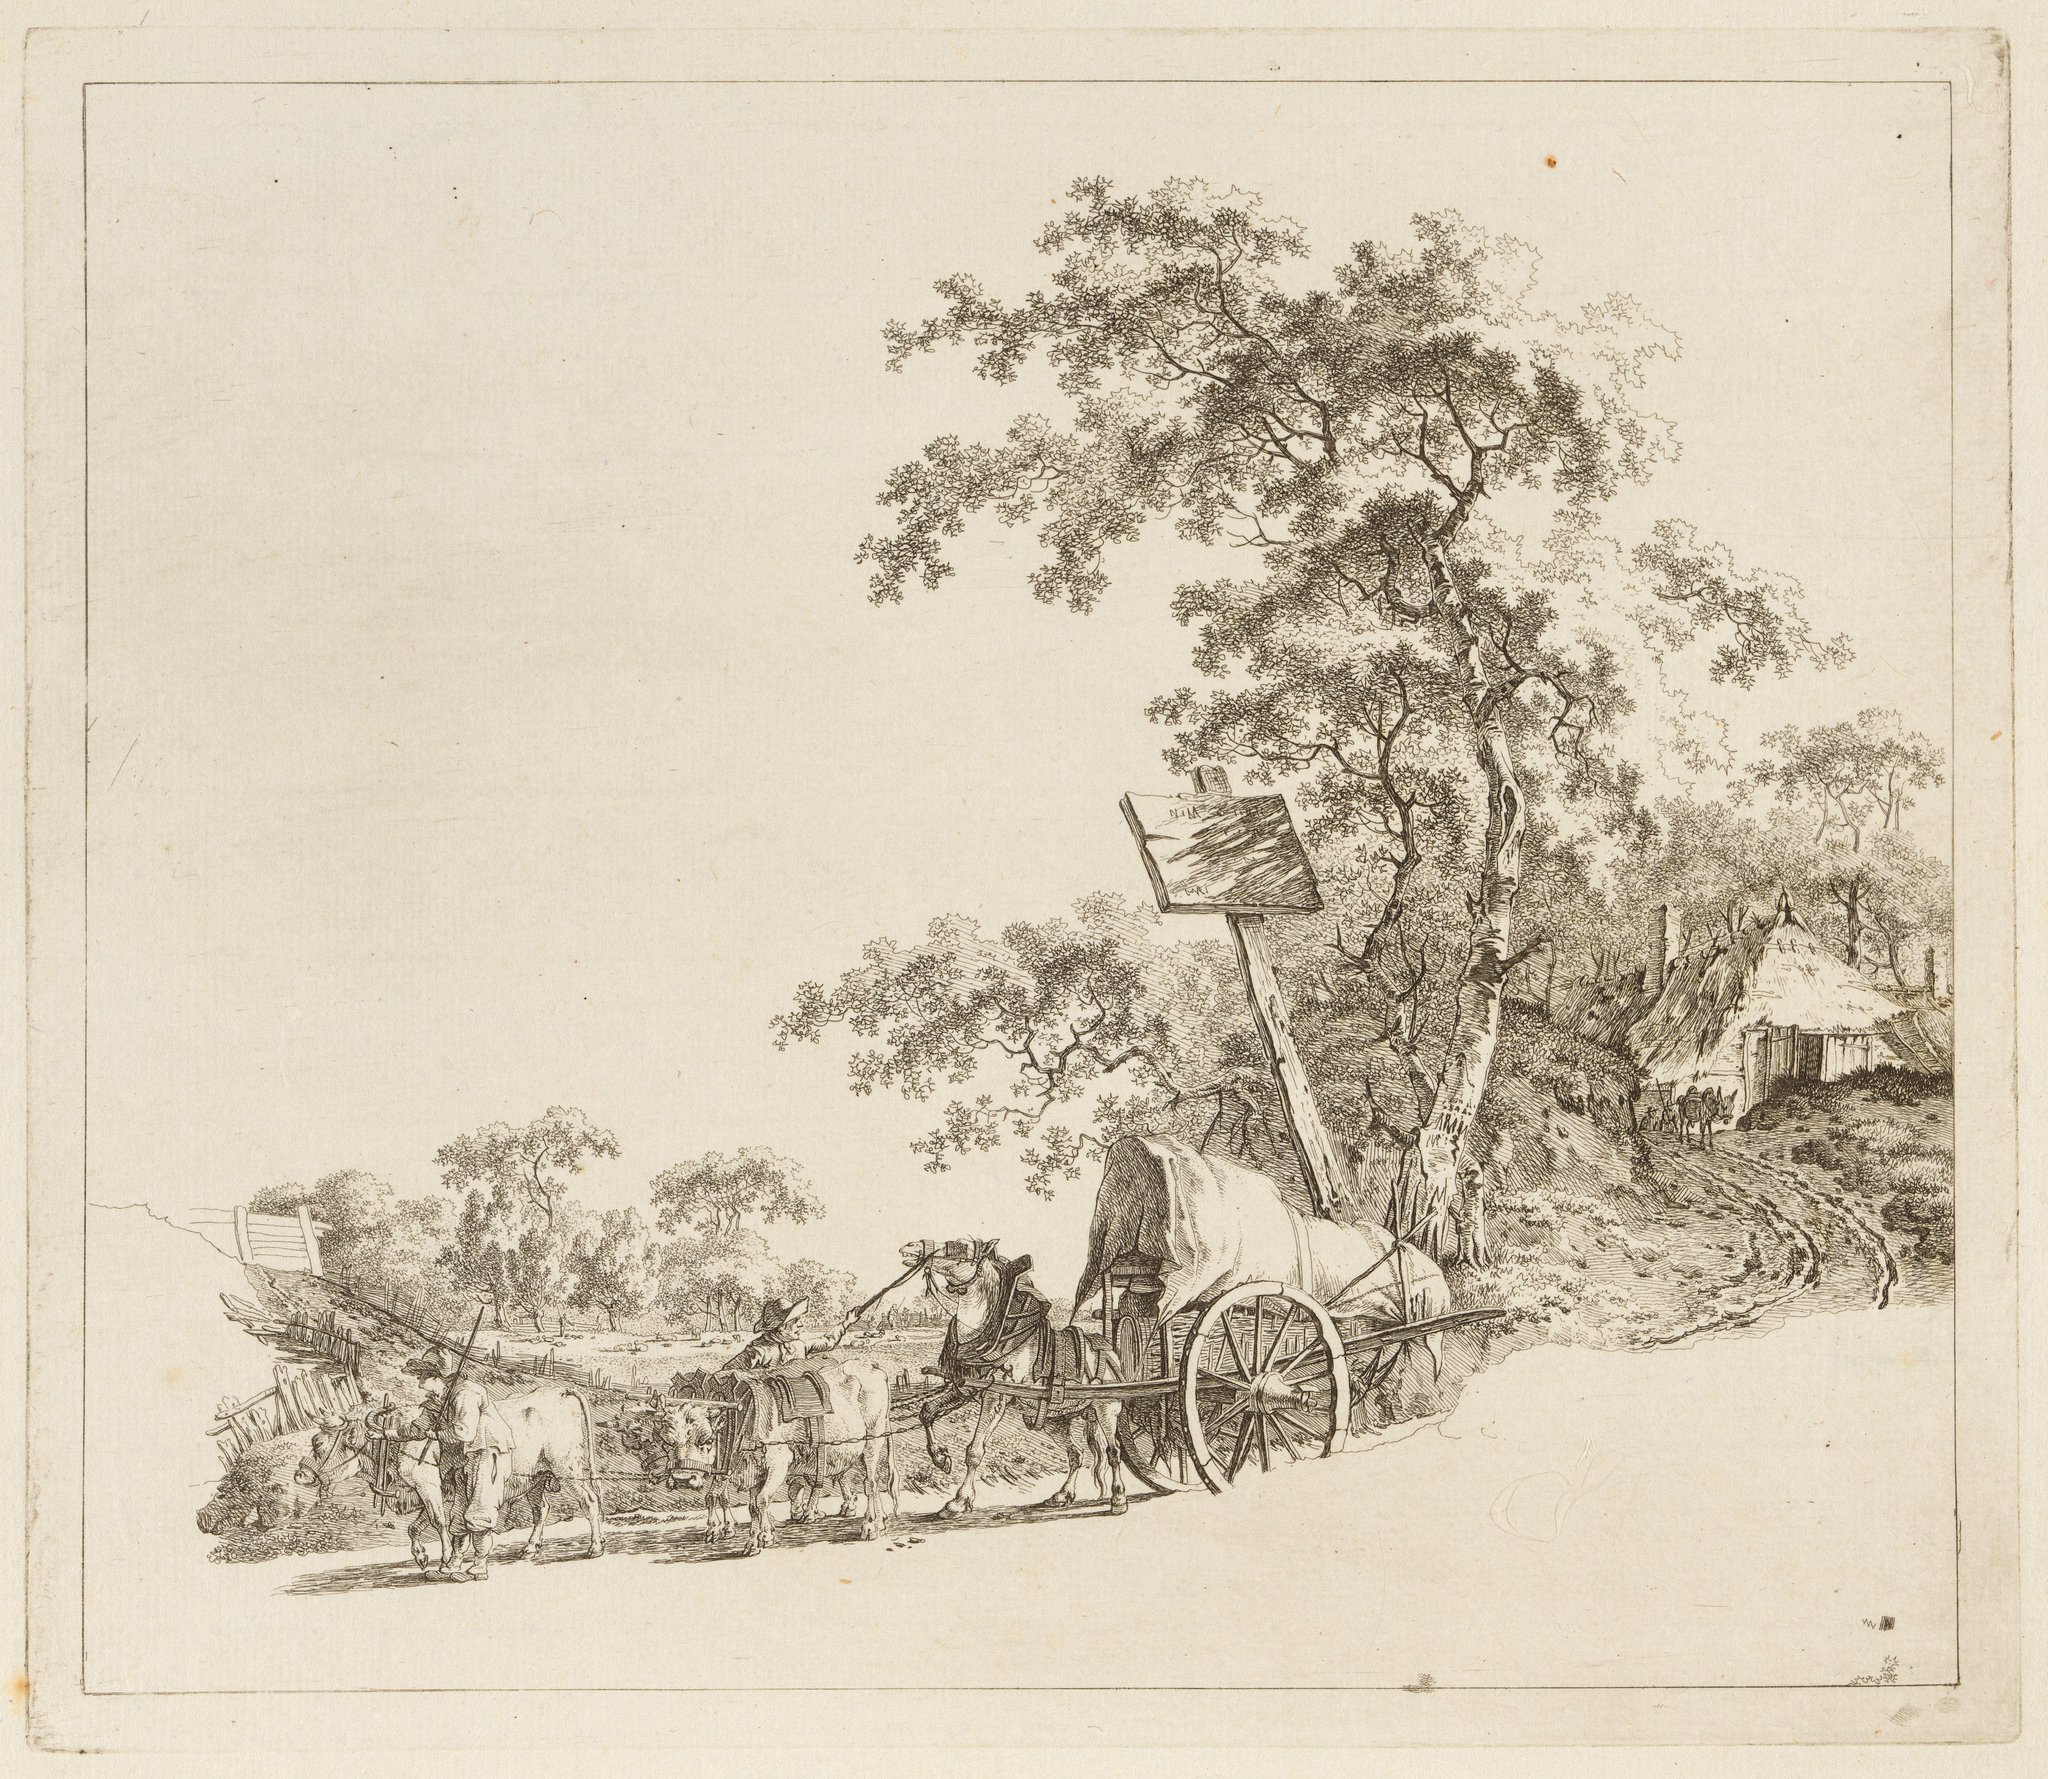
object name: print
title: Landschap met ingespannen runderen en een paard die een kar trekken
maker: barend hendrik thier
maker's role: draughtsman, print maker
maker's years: 1743-1811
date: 1780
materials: paper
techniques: etching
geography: netherlands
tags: horse, ox, (farm) wagon, freight wagon, cart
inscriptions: collector's mark: Lugt 240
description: Landschap met twee boeren bij een kar, die wordt getrokken door drie ossen en een paard. Rechtsachter een ezel bij een boerderij.